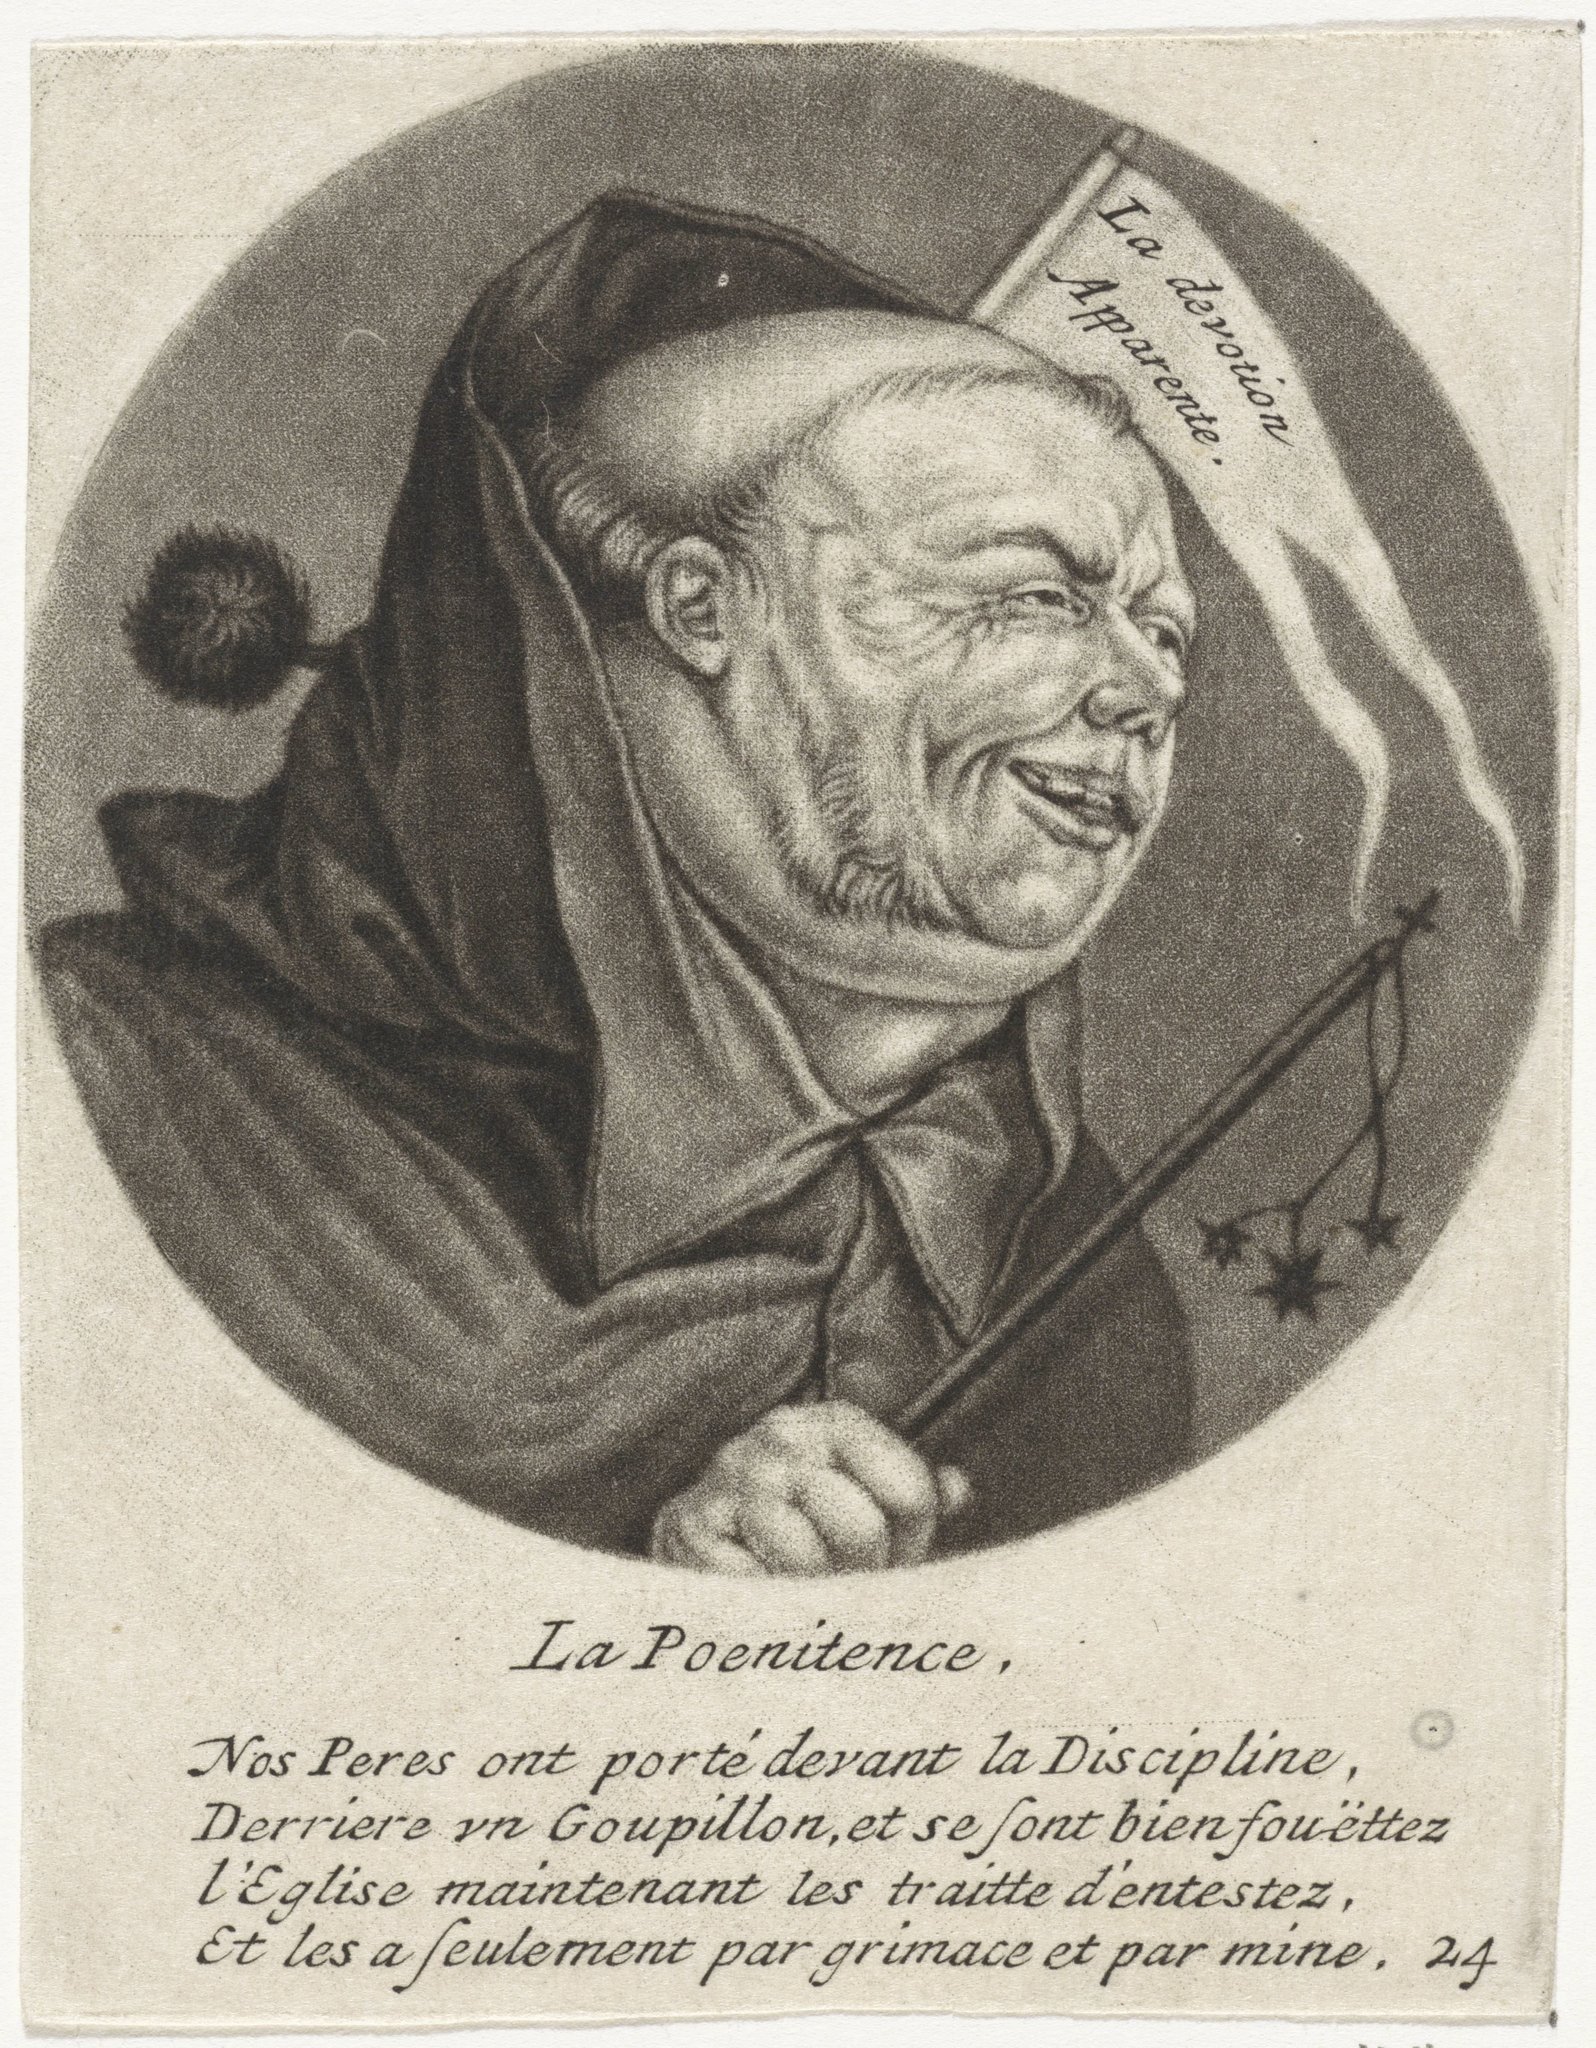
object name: print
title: Renversement de la Morale Chrétienne par les désordres du Monachisme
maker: jacob gole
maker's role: print maker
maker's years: 1660-1724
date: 1670-1724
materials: paper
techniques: engraving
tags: monk(s), friar(s), political caricatures and satires, whip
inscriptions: collector's mark: Lugt 2228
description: Een monnik met een zweep en een vlag waarop de tekst "La devotion Apparente". De prent maakt deel uit van een serie met karikaturen van de Franse geestelijkheid onder Lodewijk XIV.